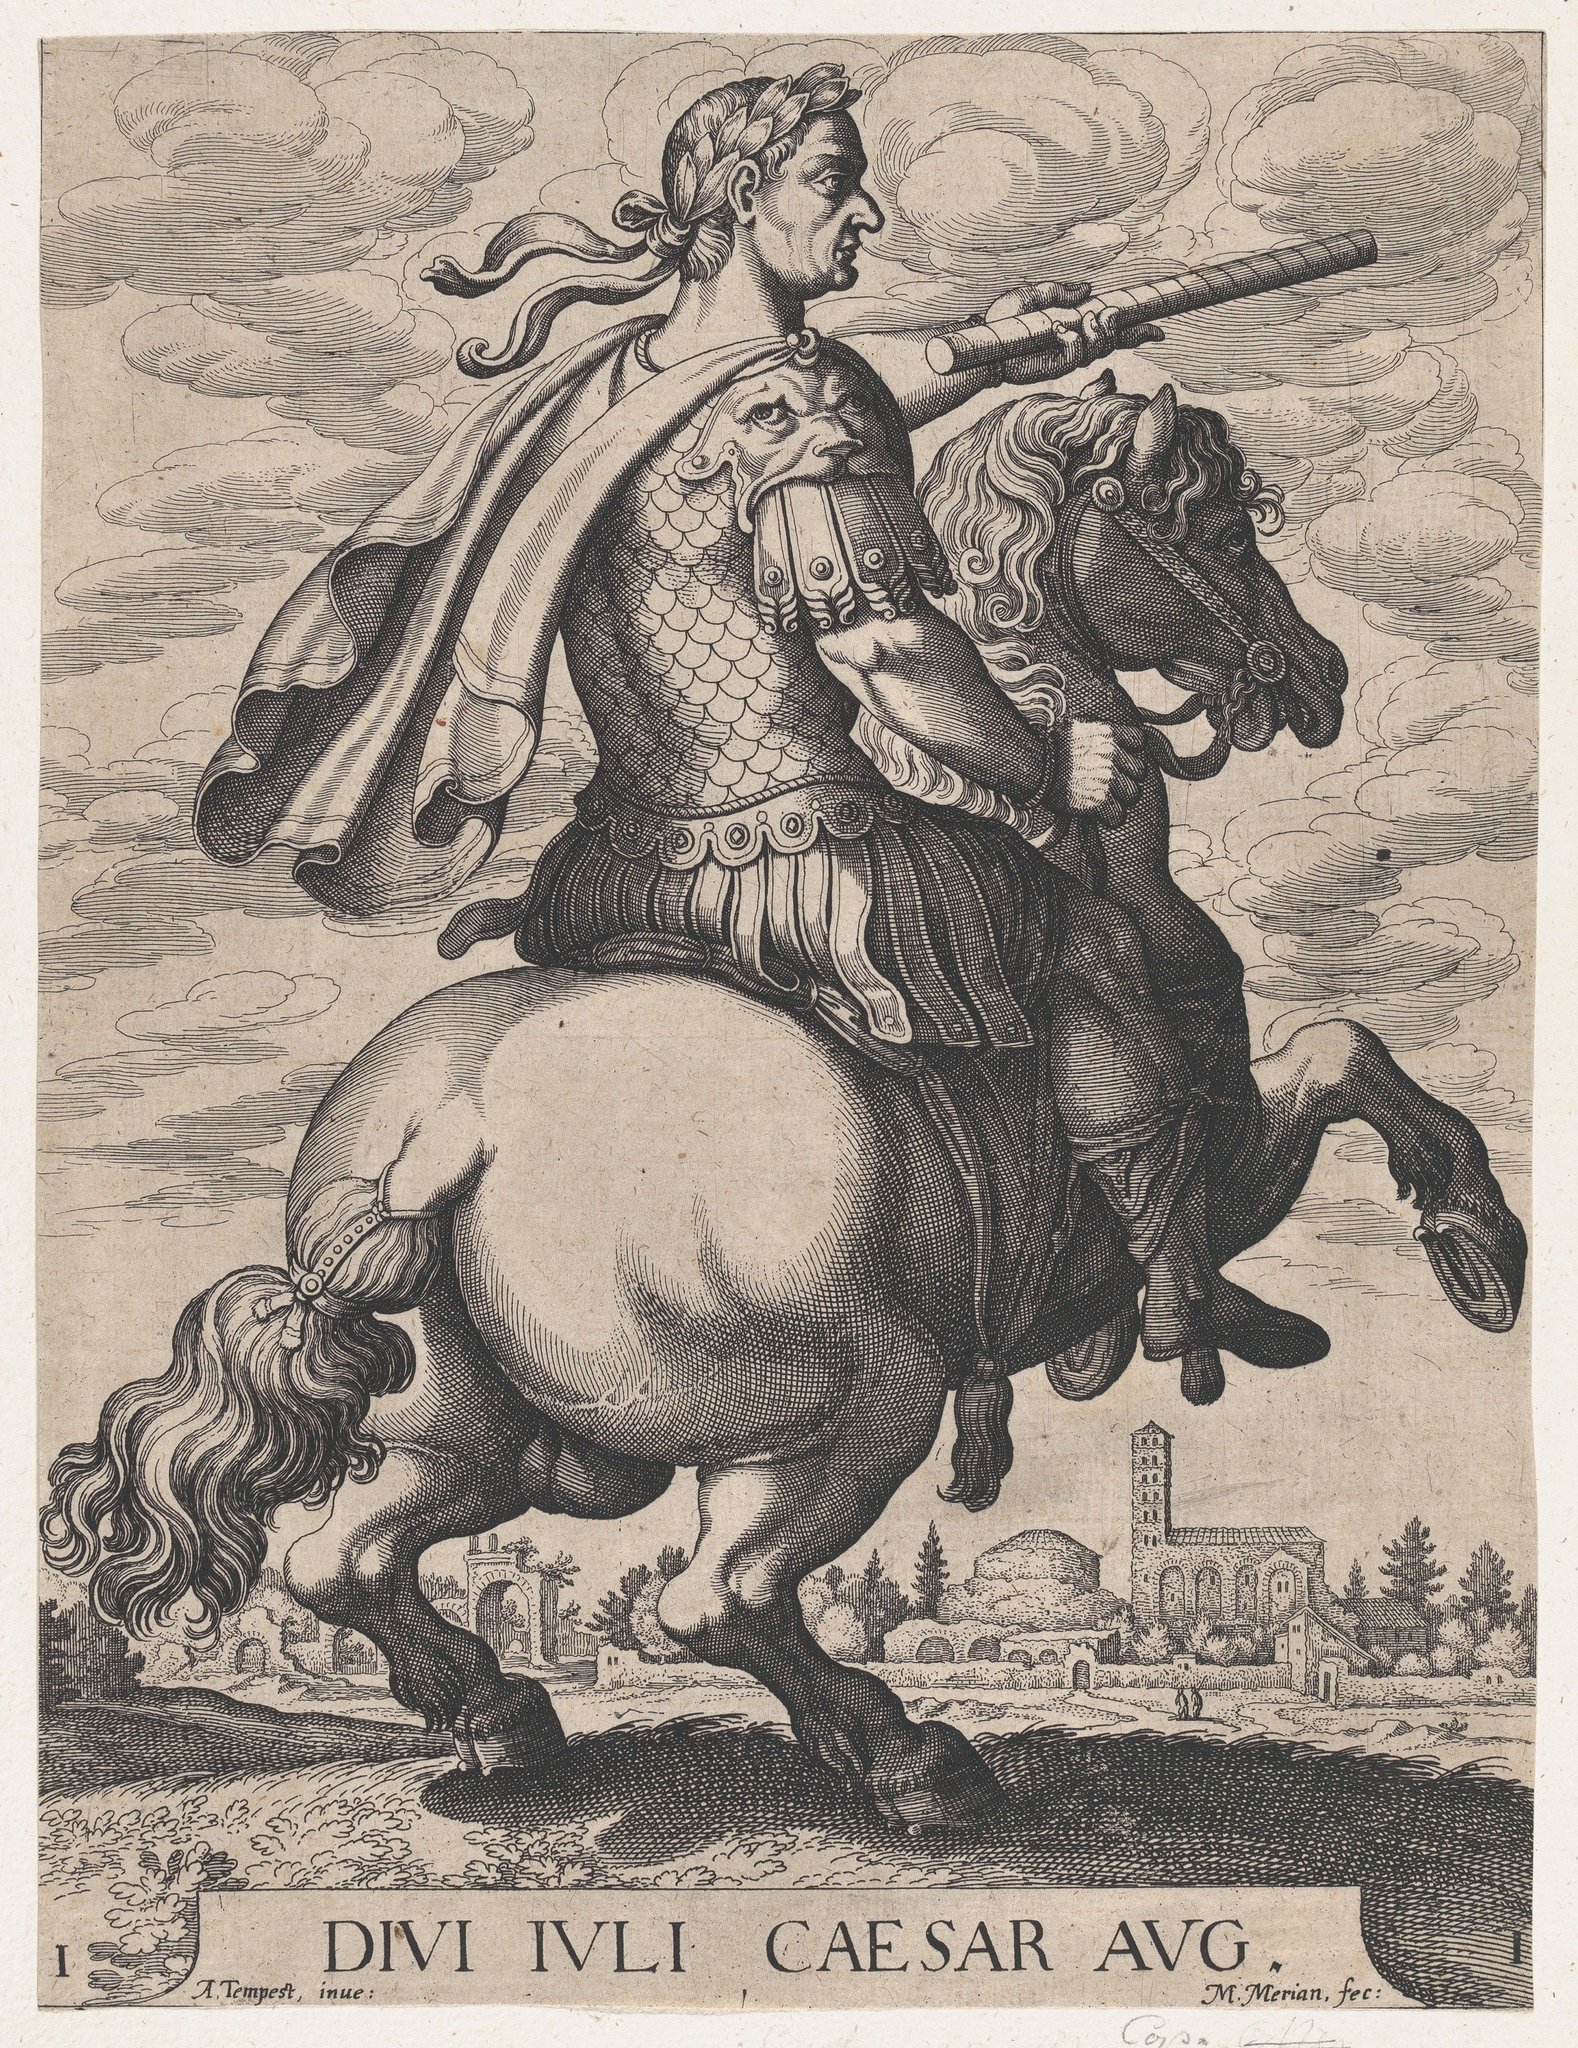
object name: print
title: Plate 1: Emperor Julius Caesar on Horseback, from ' The First Twelve Roman Caesars', after Tempesta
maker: matthäus merian the elder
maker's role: artist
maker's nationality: swiss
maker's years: 1593-1650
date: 1610-1650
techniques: etching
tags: julius caesar,horses